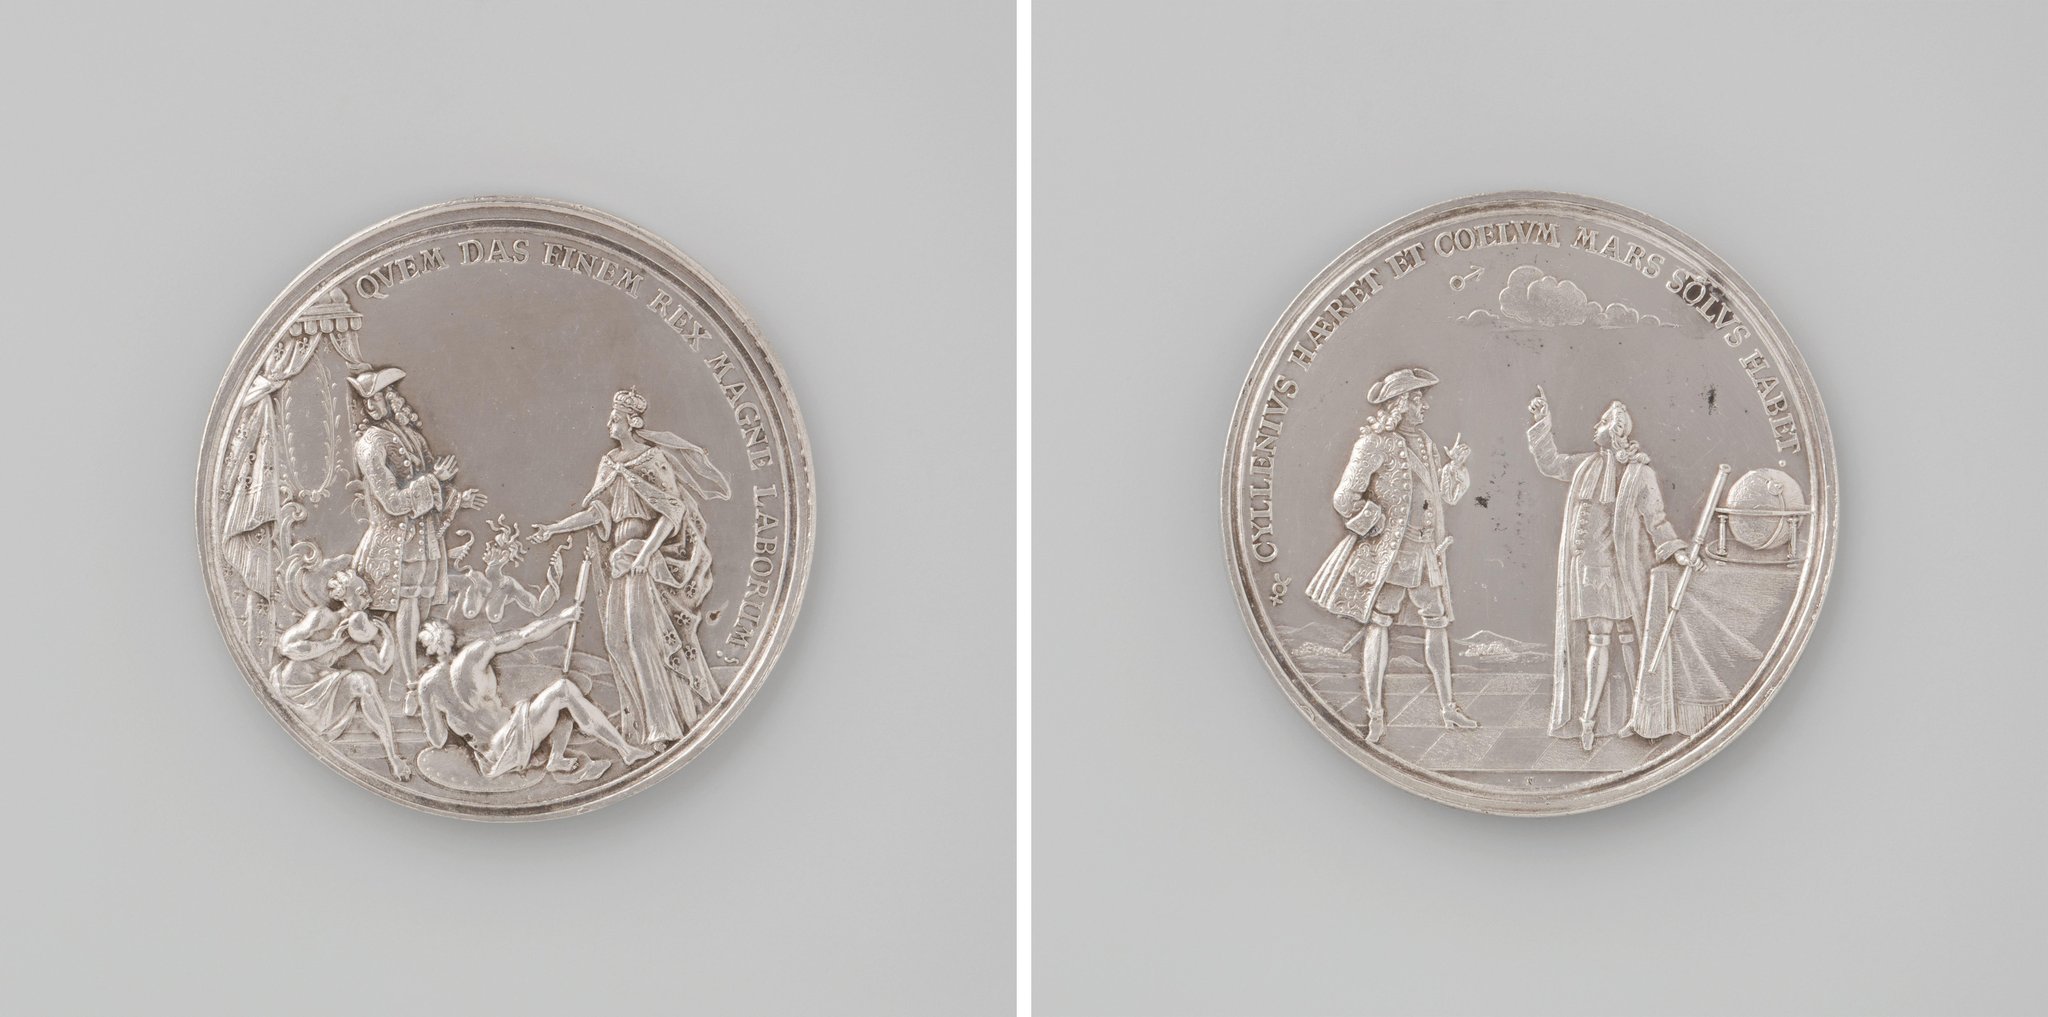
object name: history medal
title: Vredesonderhandelingen met Frankrijk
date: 1709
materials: silver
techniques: striking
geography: nuremberg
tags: netherlands, the hague, france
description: Zilveren penning. Voorzijde: Frankrijk in gedaante van gekroonde vrouw toont Lodewijk XIV drie naakte figuren: honger, oorlog en opstand, voorstellende de ellende van zijn onderdanen binnen omschrift. Keerzijde: Lodewijk XIV raadpleegt een astroloog binnen omschrift